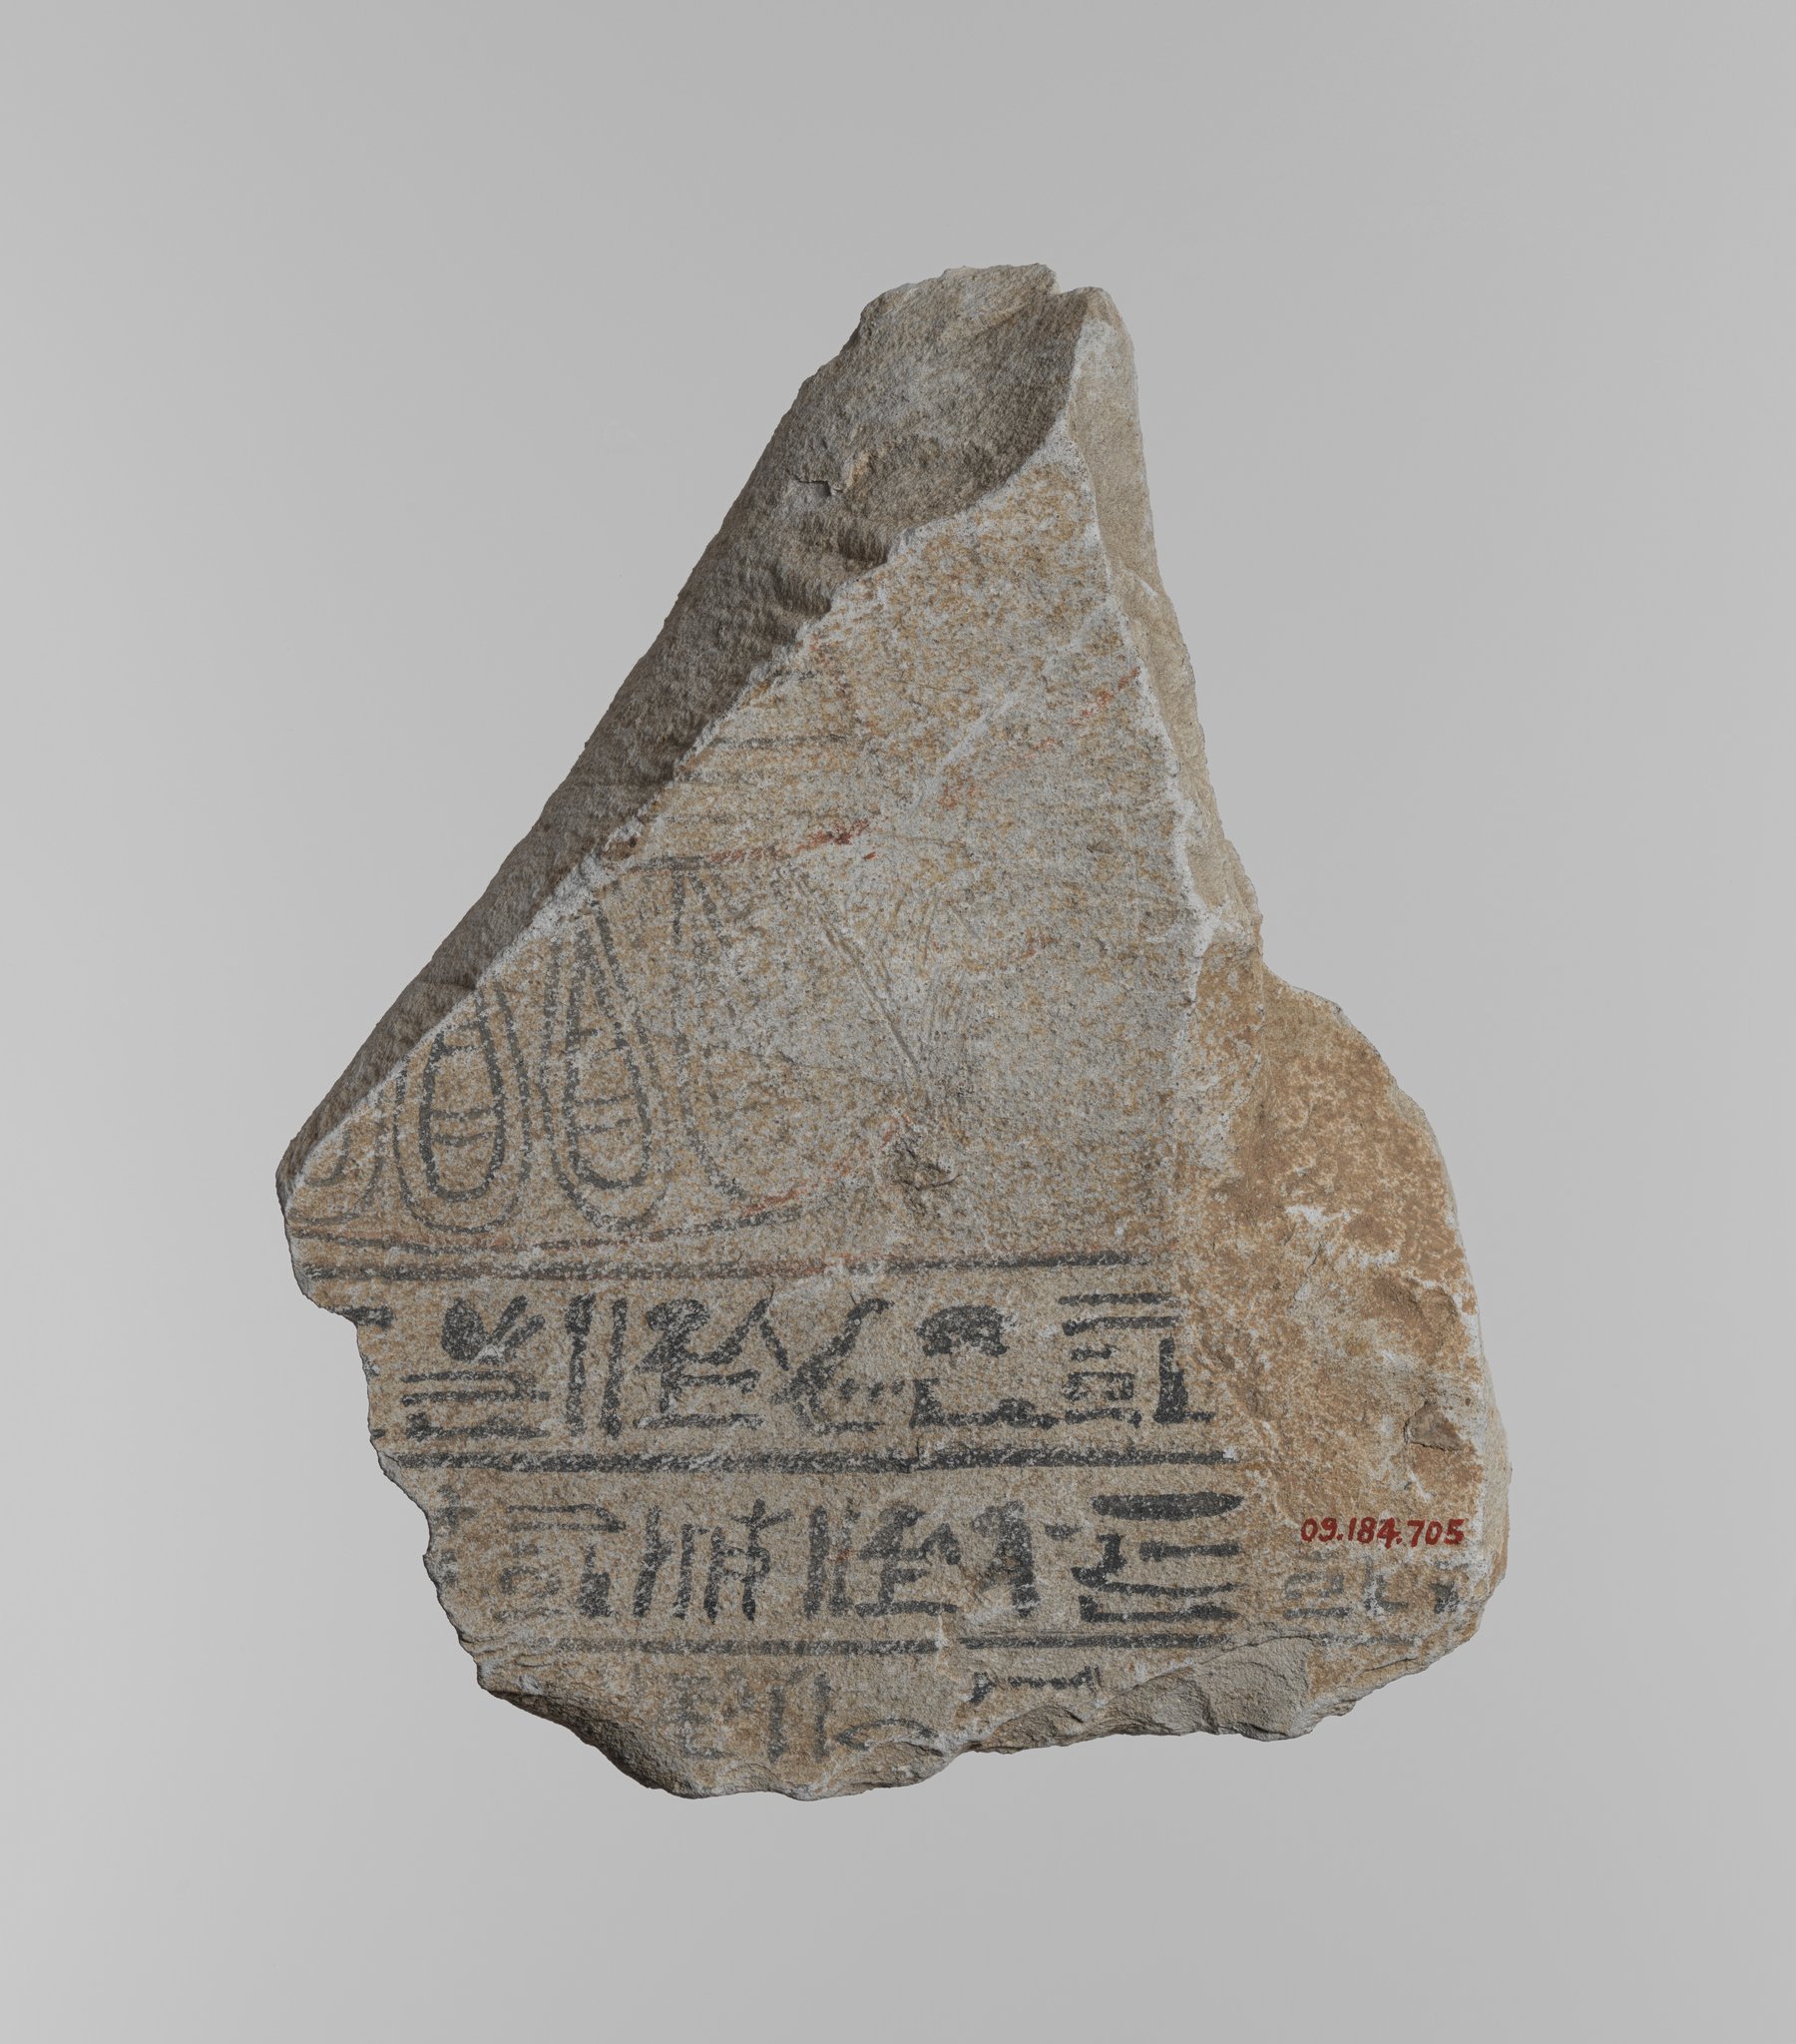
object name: ostracon, hieroglyphic, stela sketch, meretseger, khawy, nebenmaat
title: Ostracon With a Sketch for a Mereseger Stela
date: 1295-1186 BCE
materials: ink, limestone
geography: egypt